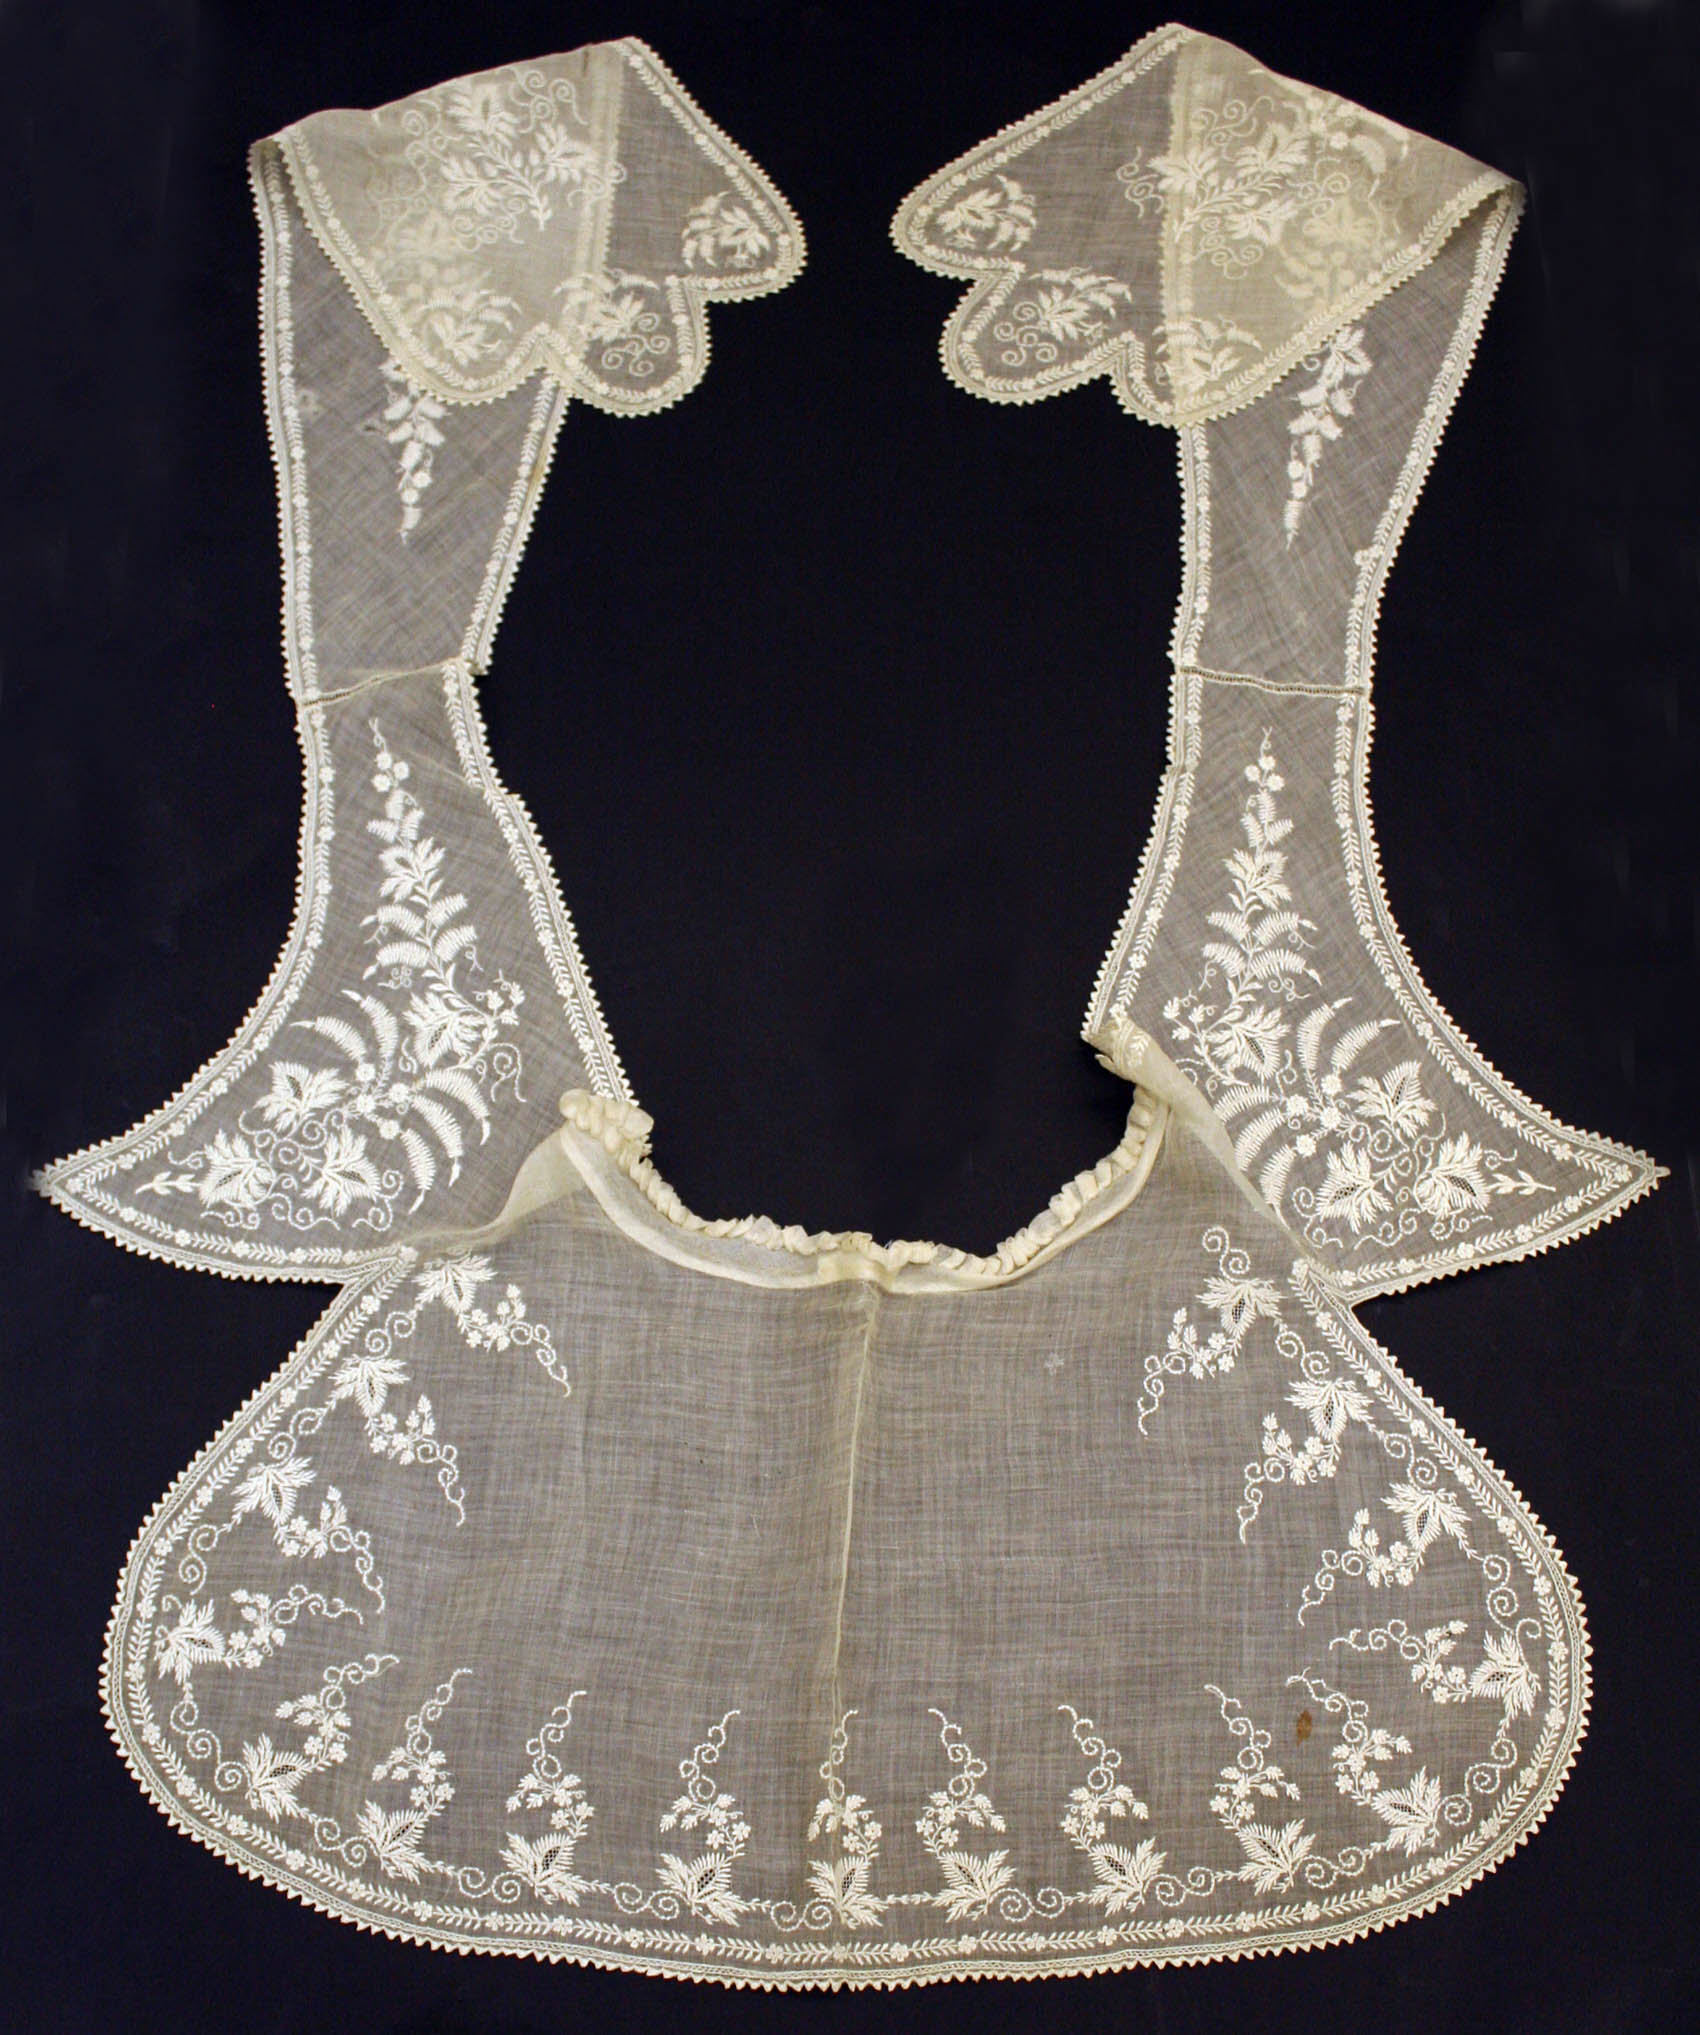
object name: collar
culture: american or european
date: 1828-1837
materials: cotton